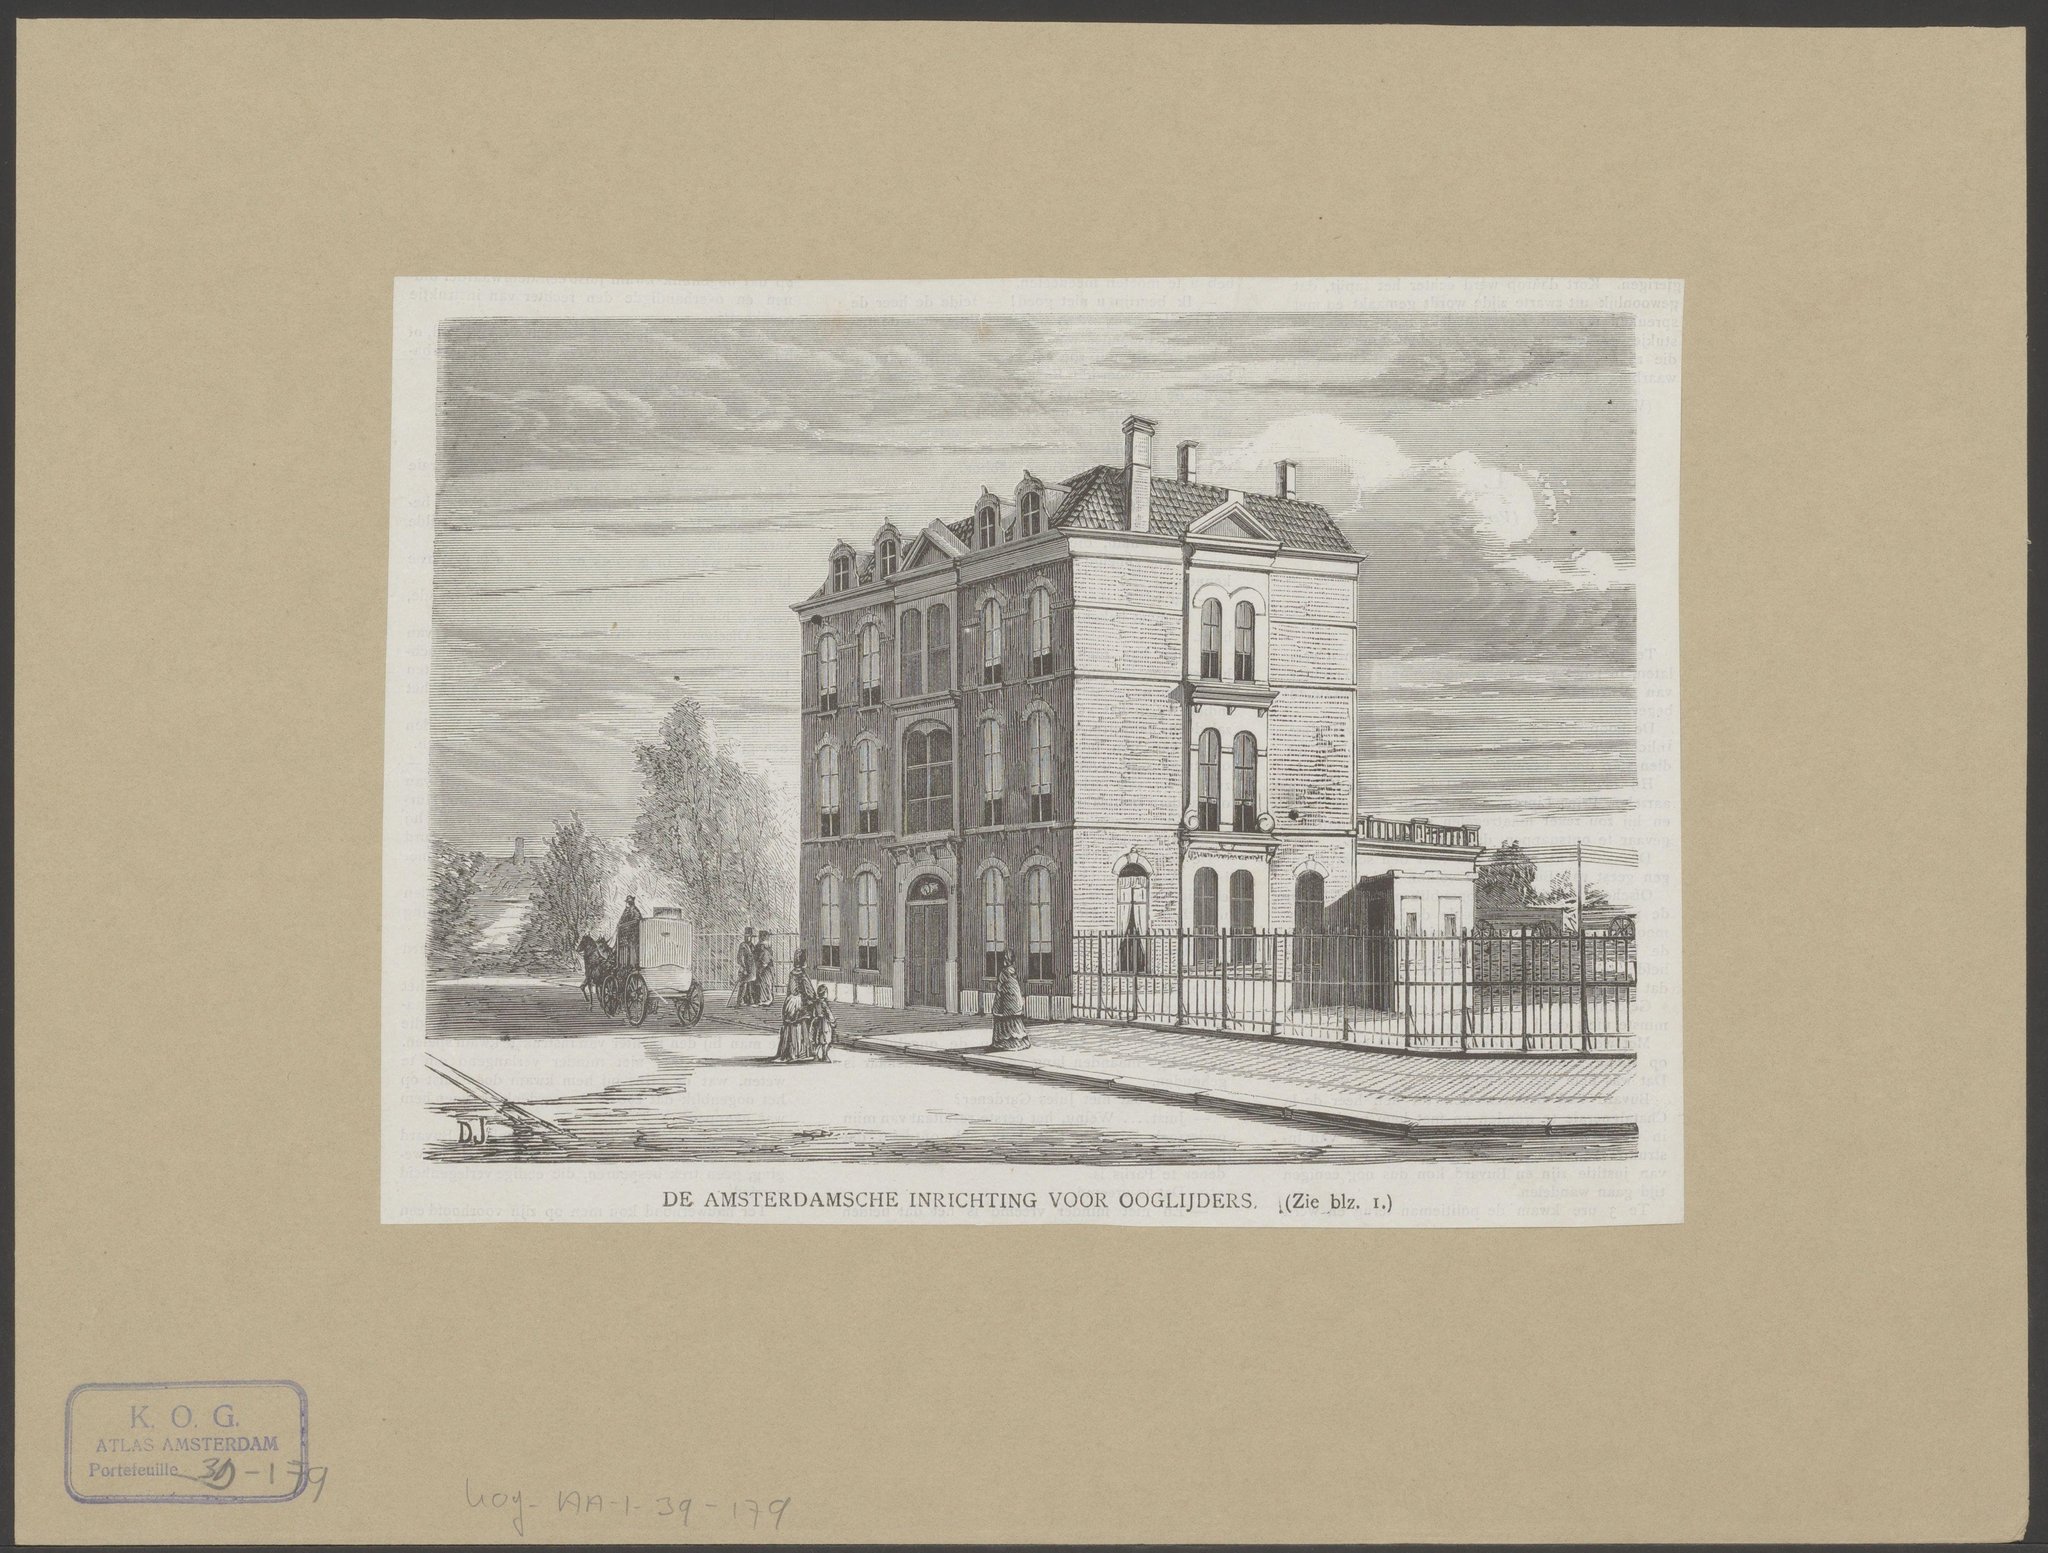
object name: print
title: De Amsterdamsche inrichting voor ooglijders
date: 1875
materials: paper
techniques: letterpress printing, engraving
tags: hospital, street (+ city(-scape) with figures, staffage)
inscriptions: collector's mark: Lugt 1641b, signature: ‘DJ’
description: Onderwerpsrubriek binnen de Atlas Amsterdam: Armwezen en liefdadige instellingen: V. Ziekenhuizen: Inrichting voor Oogleiders.